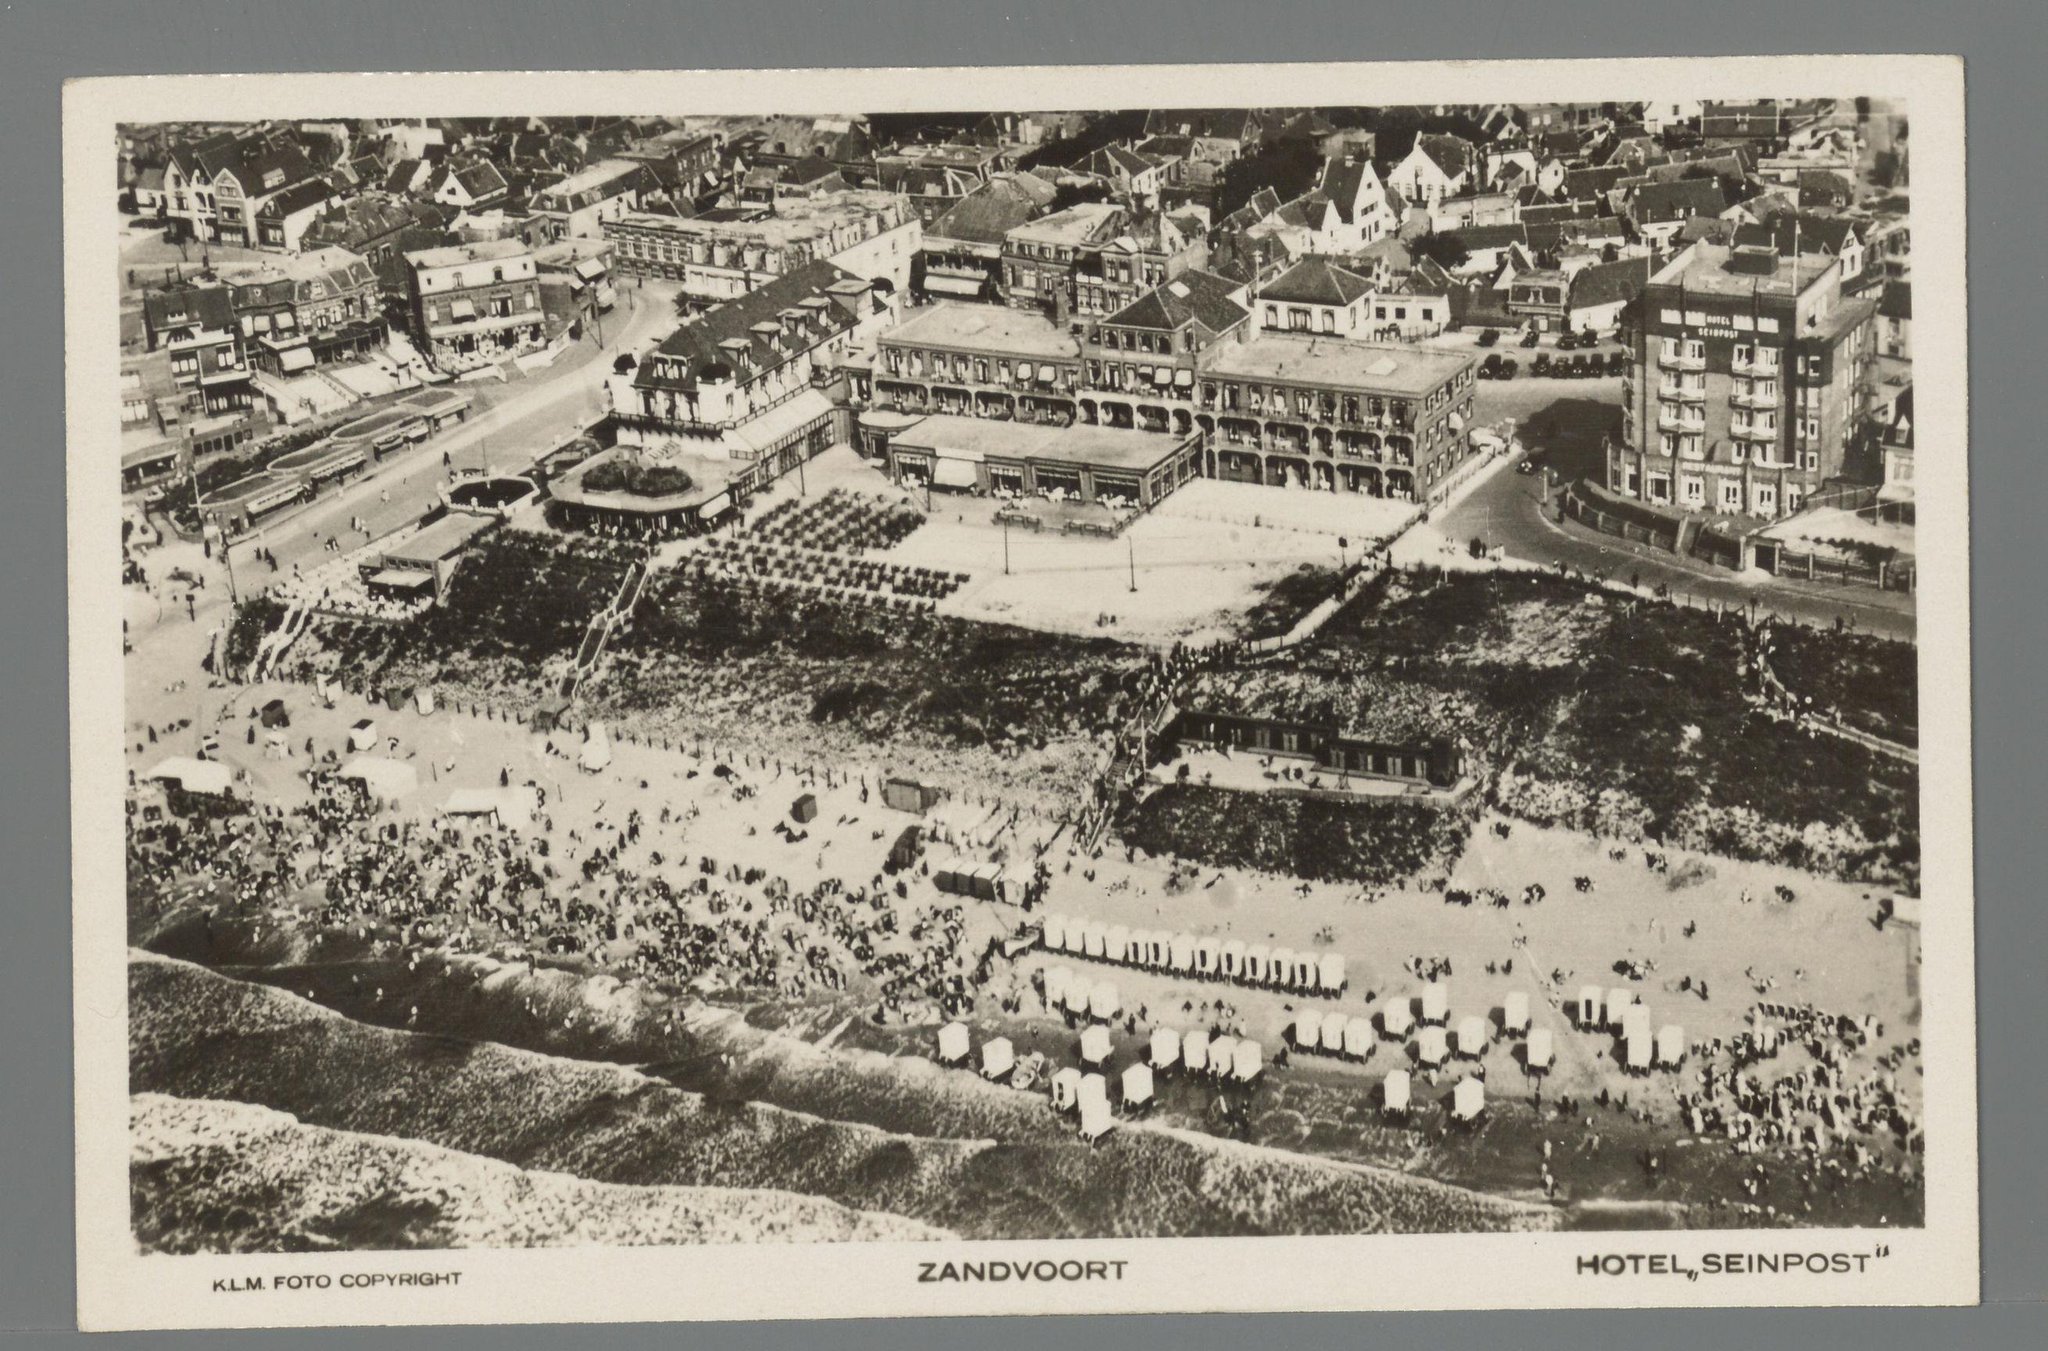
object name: photograph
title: Zandvoort. Hotel "Seinpost"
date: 1929-1943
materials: photographic support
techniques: gelatin silver print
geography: amsterdam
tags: beach (as place of recreation), hotel, hostelry, inn